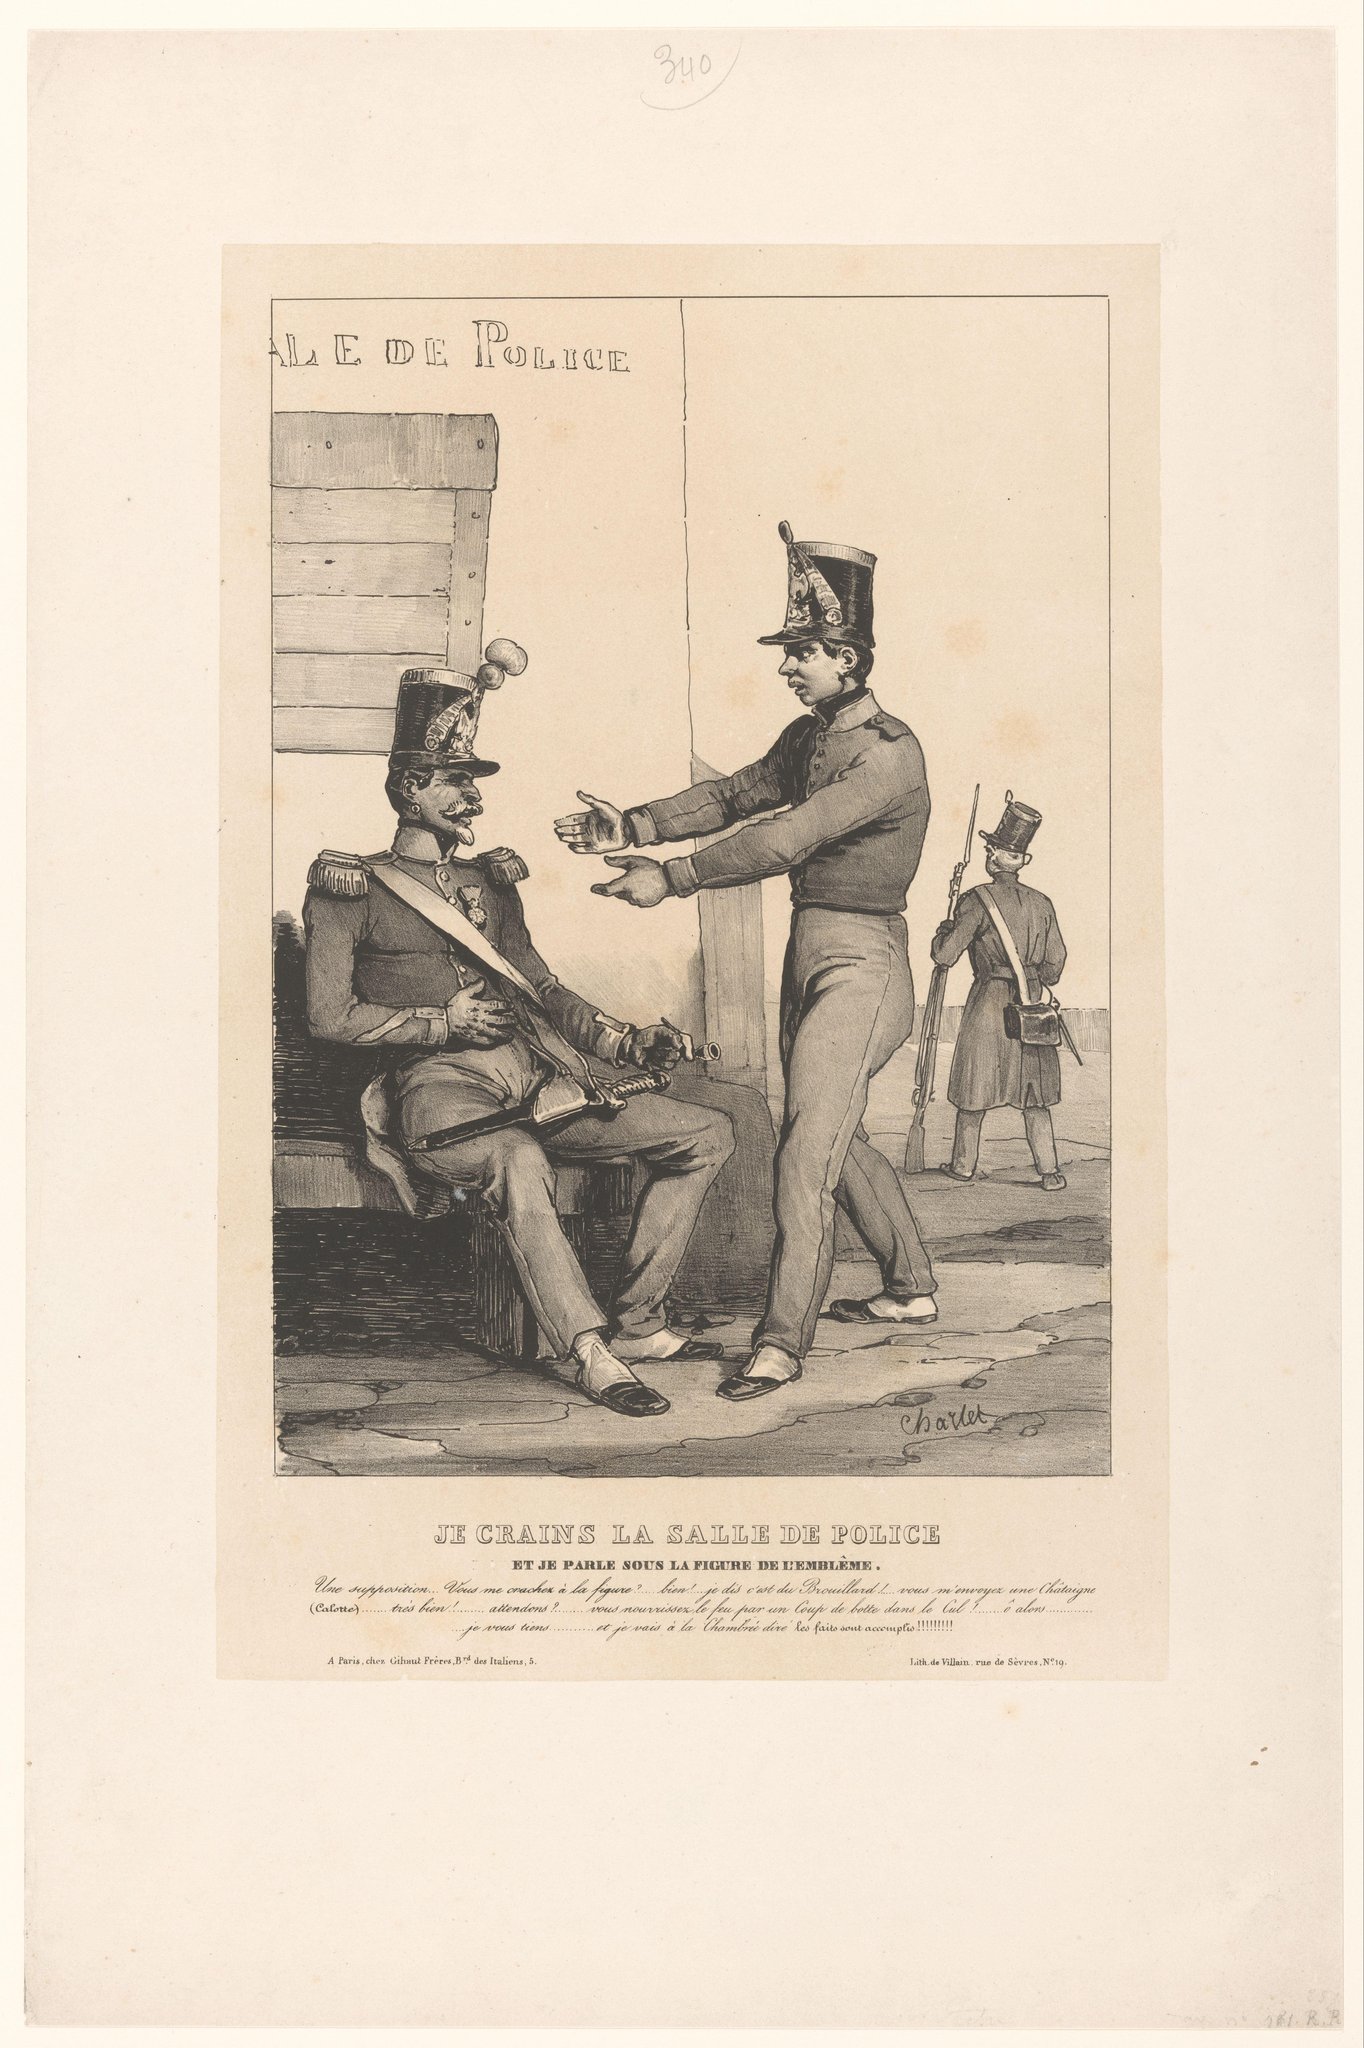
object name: print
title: Je crains la salle de police (...)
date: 1840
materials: paper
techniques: tone lithography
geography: paris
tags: private soldier, officer, conversation, dialogue; conversation piece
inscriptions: number: ‘340’, collector's mark: Lugt 2166, collector's mark: Lugt 2760, number: ‘66’